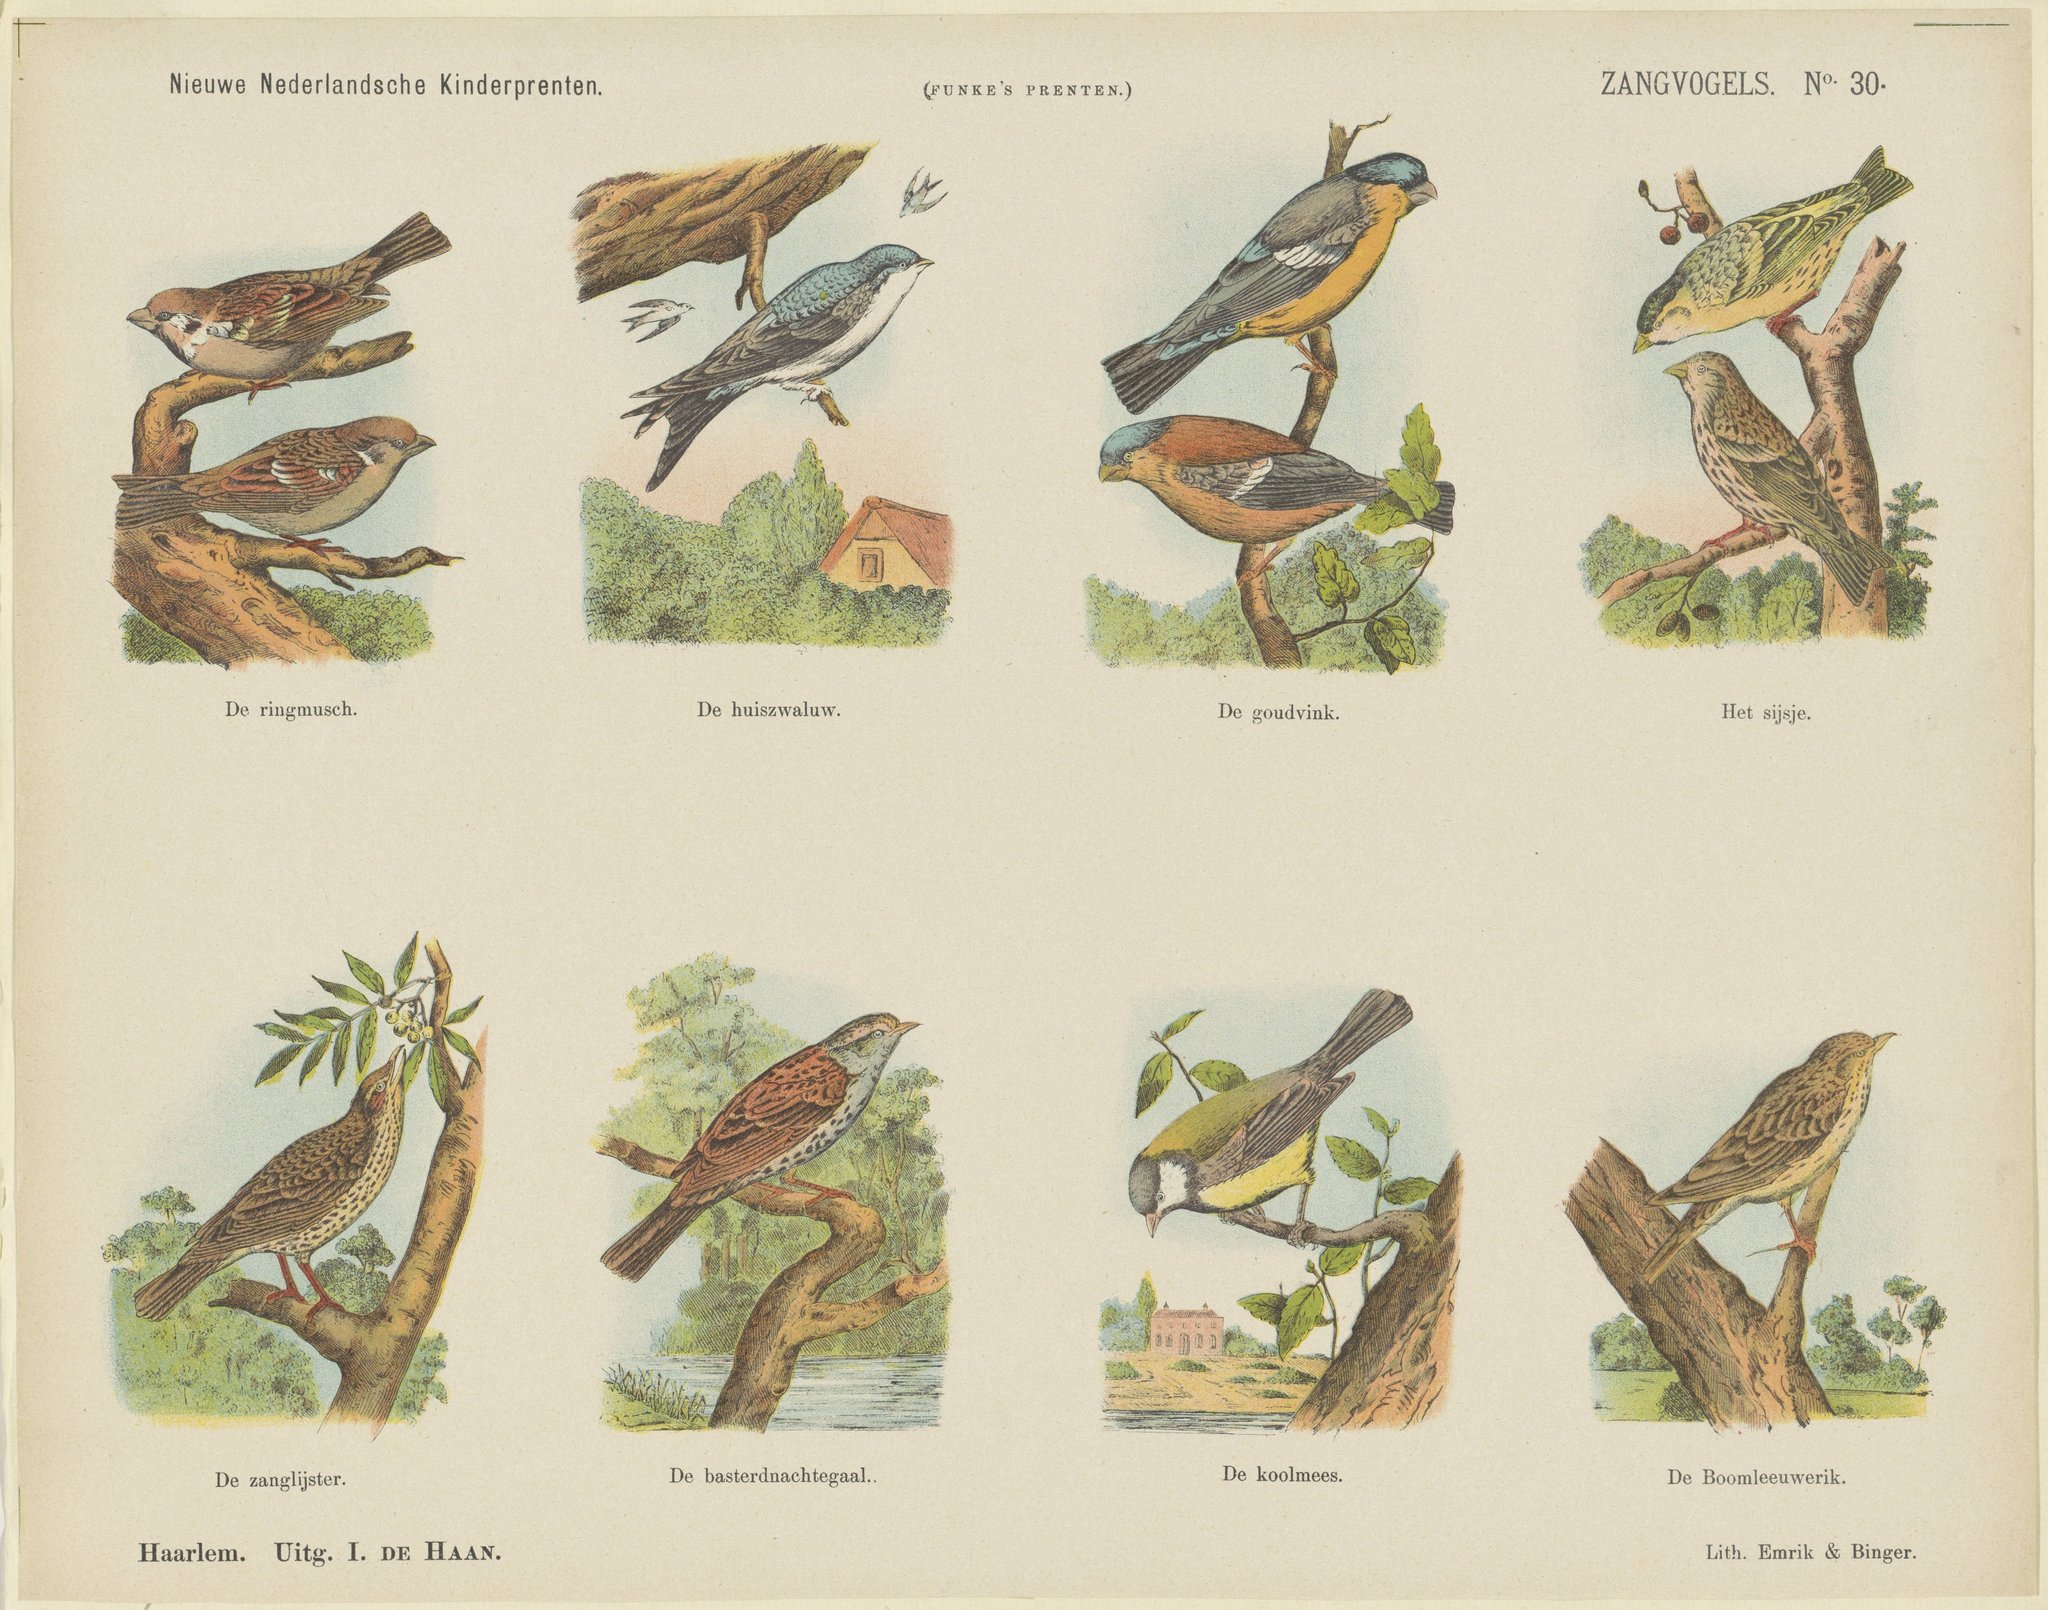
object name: print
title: Zangvogels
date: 1875-1903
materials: paper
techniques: lithograph, letterpress printing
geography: haarlem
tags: song-birds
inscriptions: collector's mark: Lugt 2760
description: Blad met 8 voorstellingen van zangvogels, onder andere een goudvink, een zanglijster en een koolmees. Onder elke afbeelding een onderschrift. Genummerd rechtsboven: No. 30.